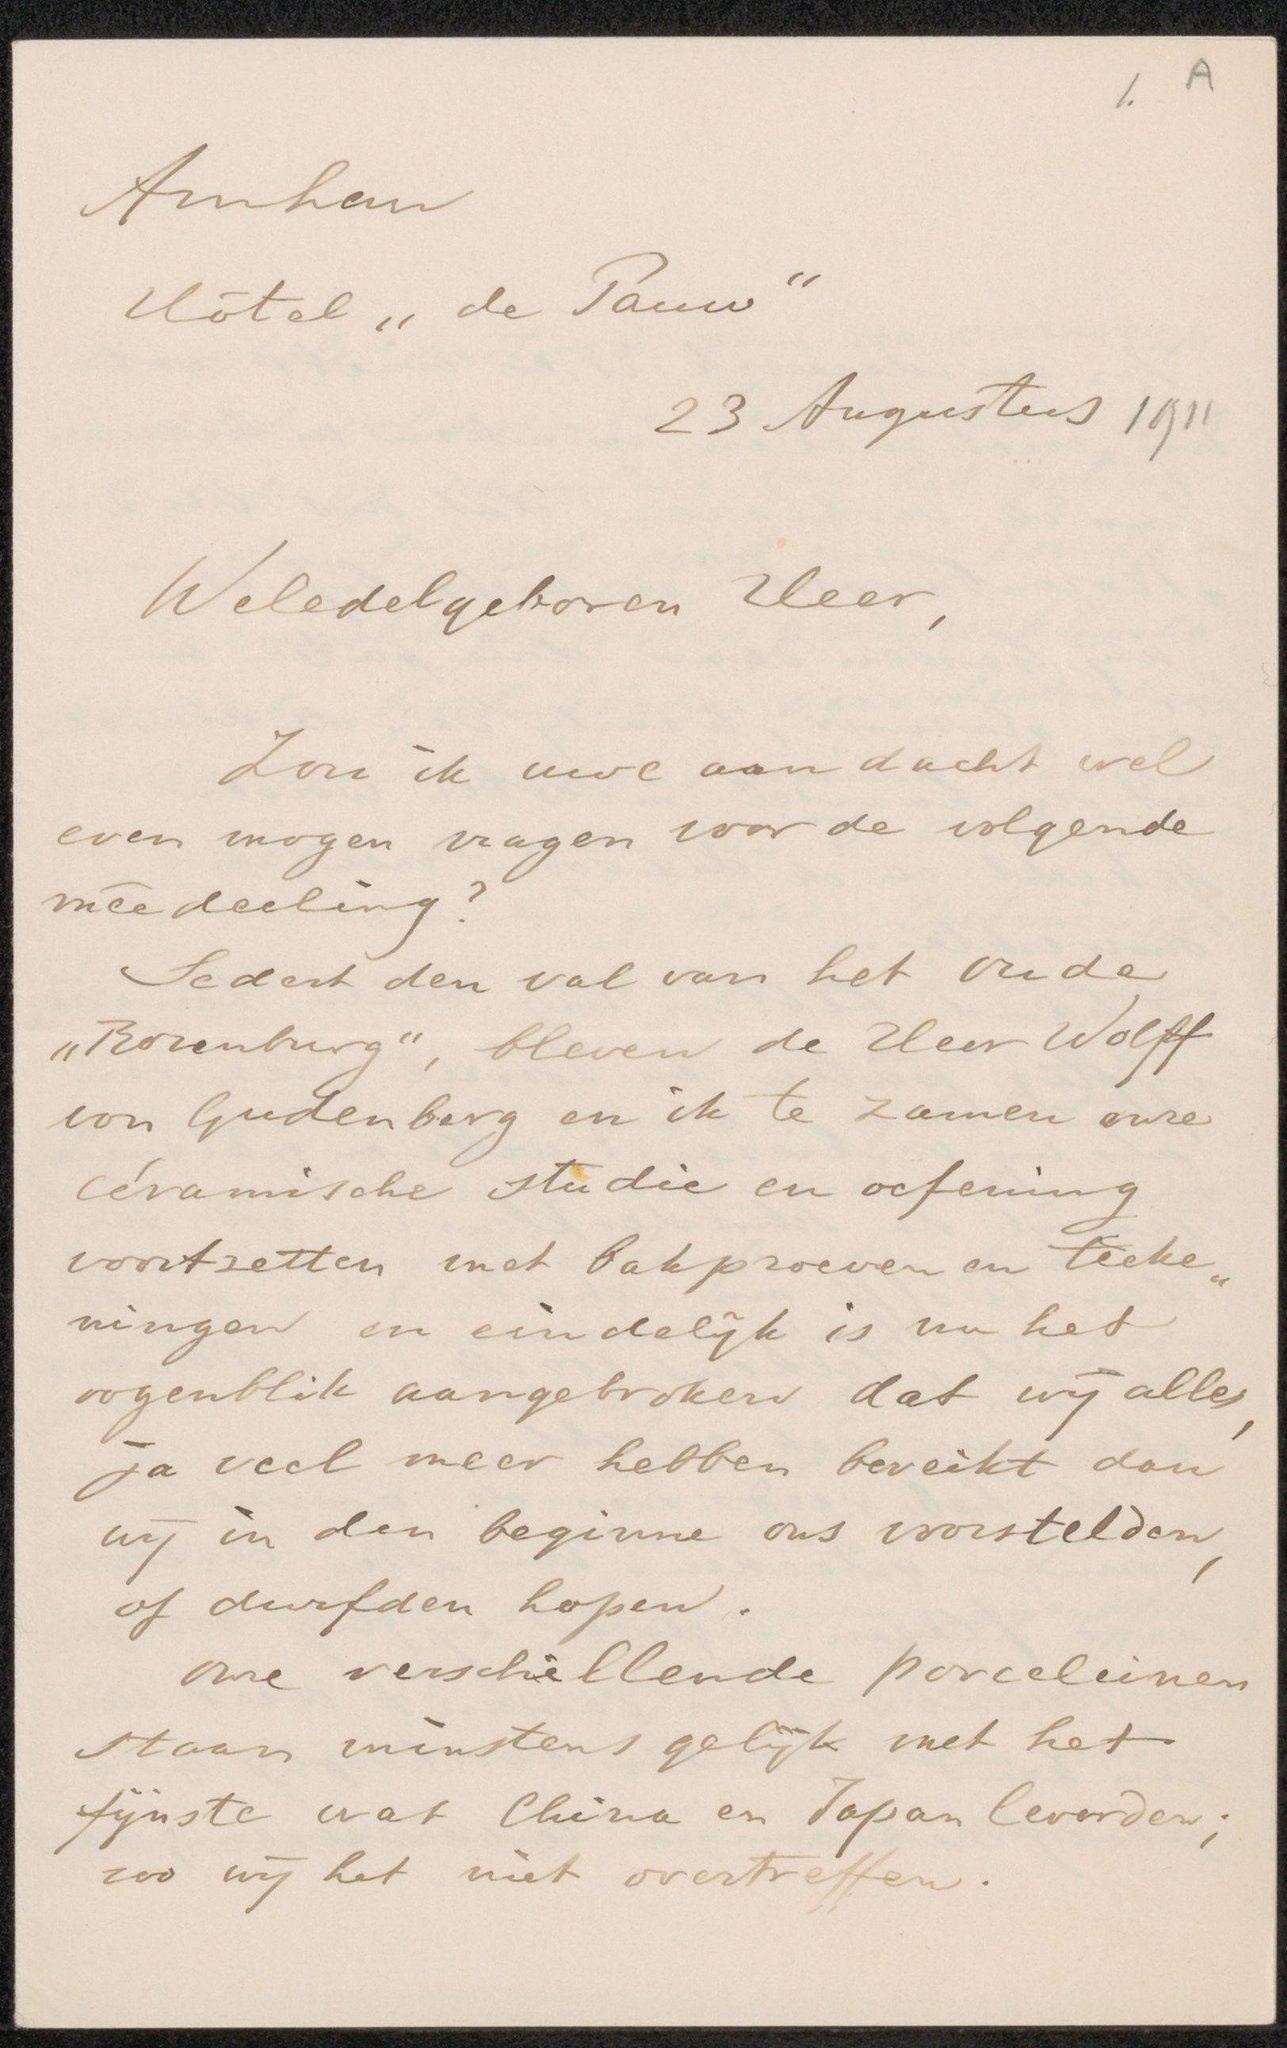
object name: letter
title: Brief aan Pieter Haverkorn van Rijsewijk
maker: theo colenbrander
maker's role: draughtsman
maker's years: 1841-1930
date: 1851-1915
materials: ink, paper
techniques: pen, writing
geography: arnhem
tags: w.g. eberson, pieter haverkorn van rijsewijk, applied arts, arts and crafts; industrial design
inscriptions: collector's mark: ‘RPK’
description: RP-D-COLENBRANDER.T.C.-1A en RP-D-COLENBRANDER-1B tot en met RP-D-COLENBRANDER-1H vormen een doorlopende brief. RP-D-COLENBRANDER-1I is verstuurd als bijlage bij deze brief.